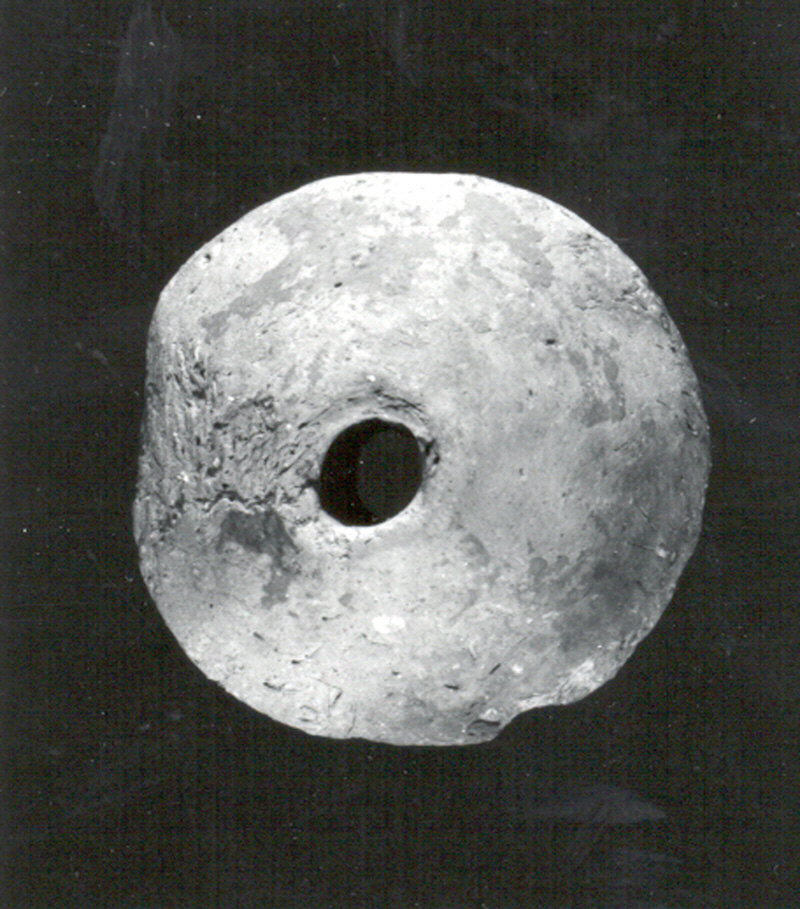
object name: whorl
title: Spindle whorl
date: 6000-5001 BCE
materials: ceramic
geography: iran